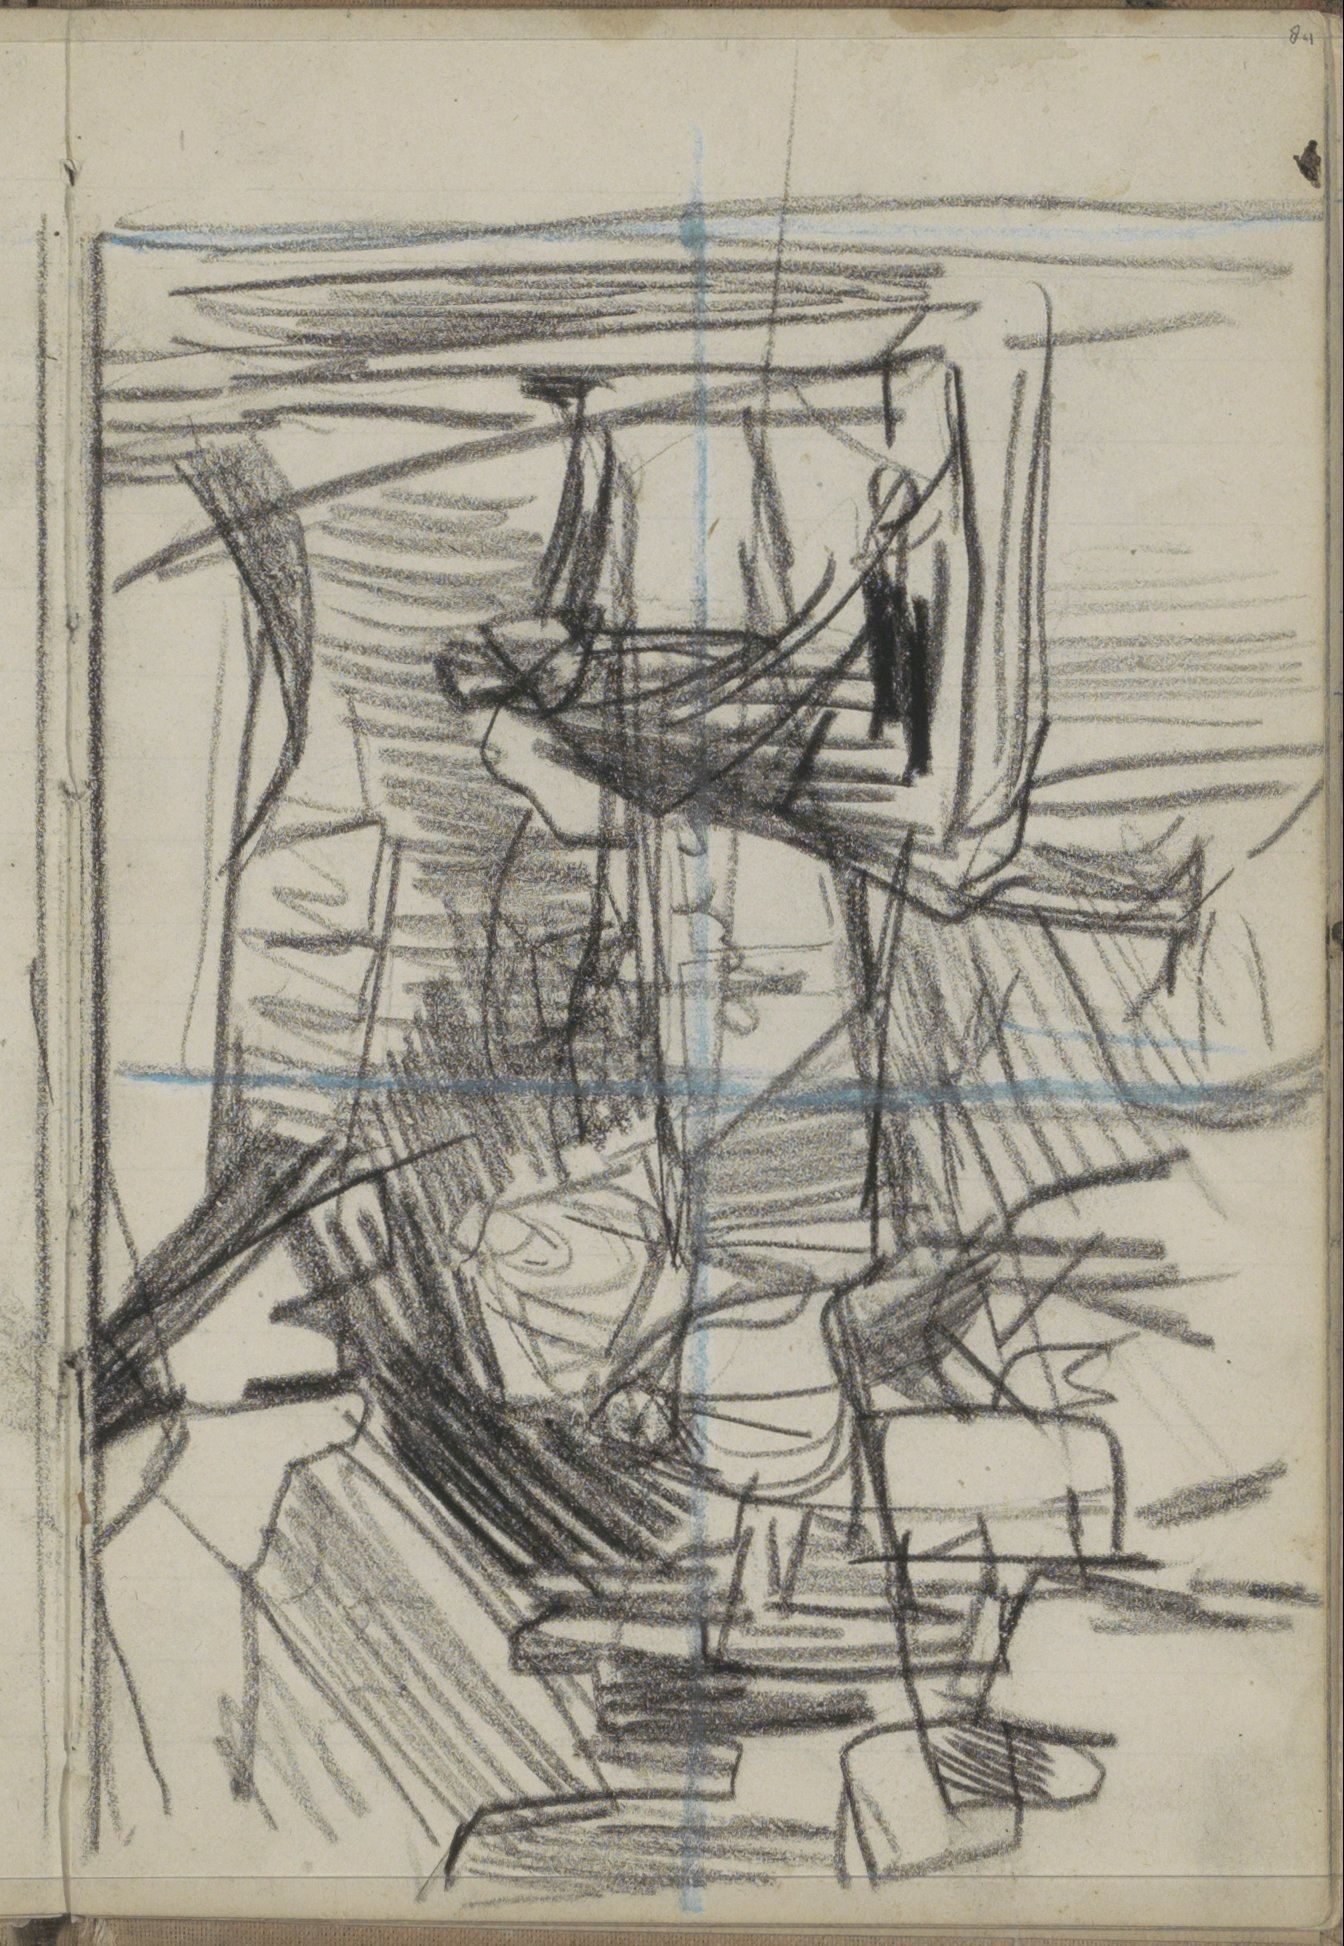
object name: sketchbook leaf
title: Interieur met een figuur bij een tafel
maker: marius bauer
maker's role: draughtsman, print maker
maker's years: 1867-1932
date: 1888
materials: chalk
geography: istanbul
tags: asiatic races and peoples, table, interior of the house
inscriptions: kleurnotitie, handgeschreven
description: De voorstelling is door middel van een raster in vieren gedeeld. Pagina 84 uit een schetsboek met 58 bladen.